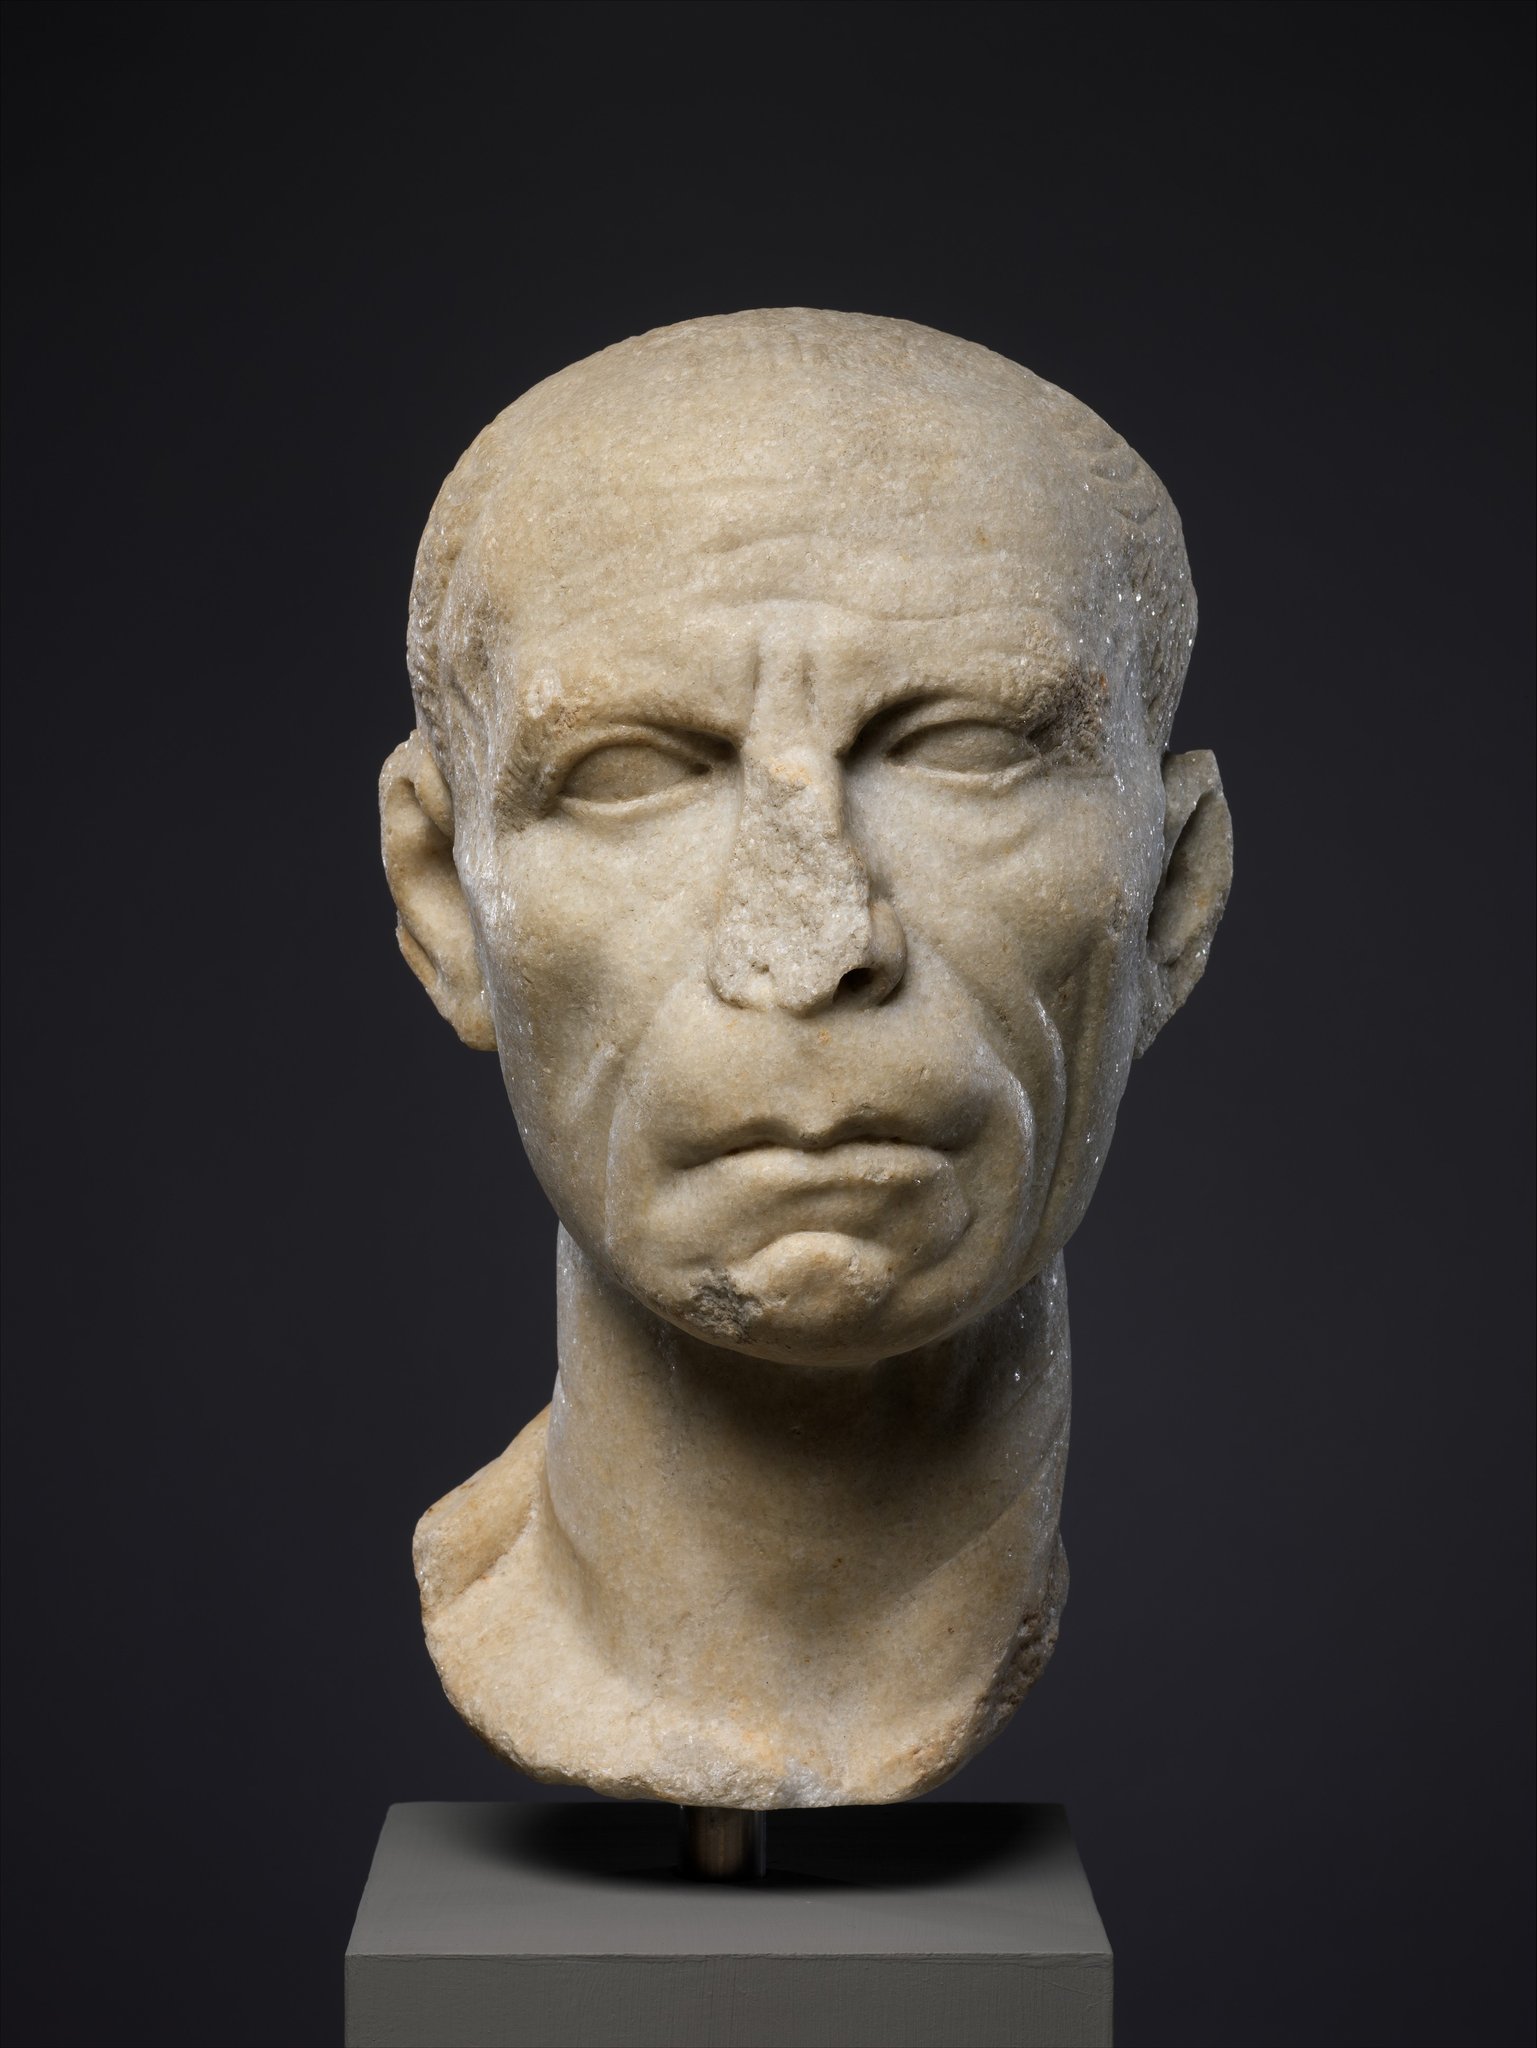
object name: portrait bust of a man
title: Marble portrait of a man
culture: roman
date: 34-1 BCE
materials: marble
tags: heads,men,portraits